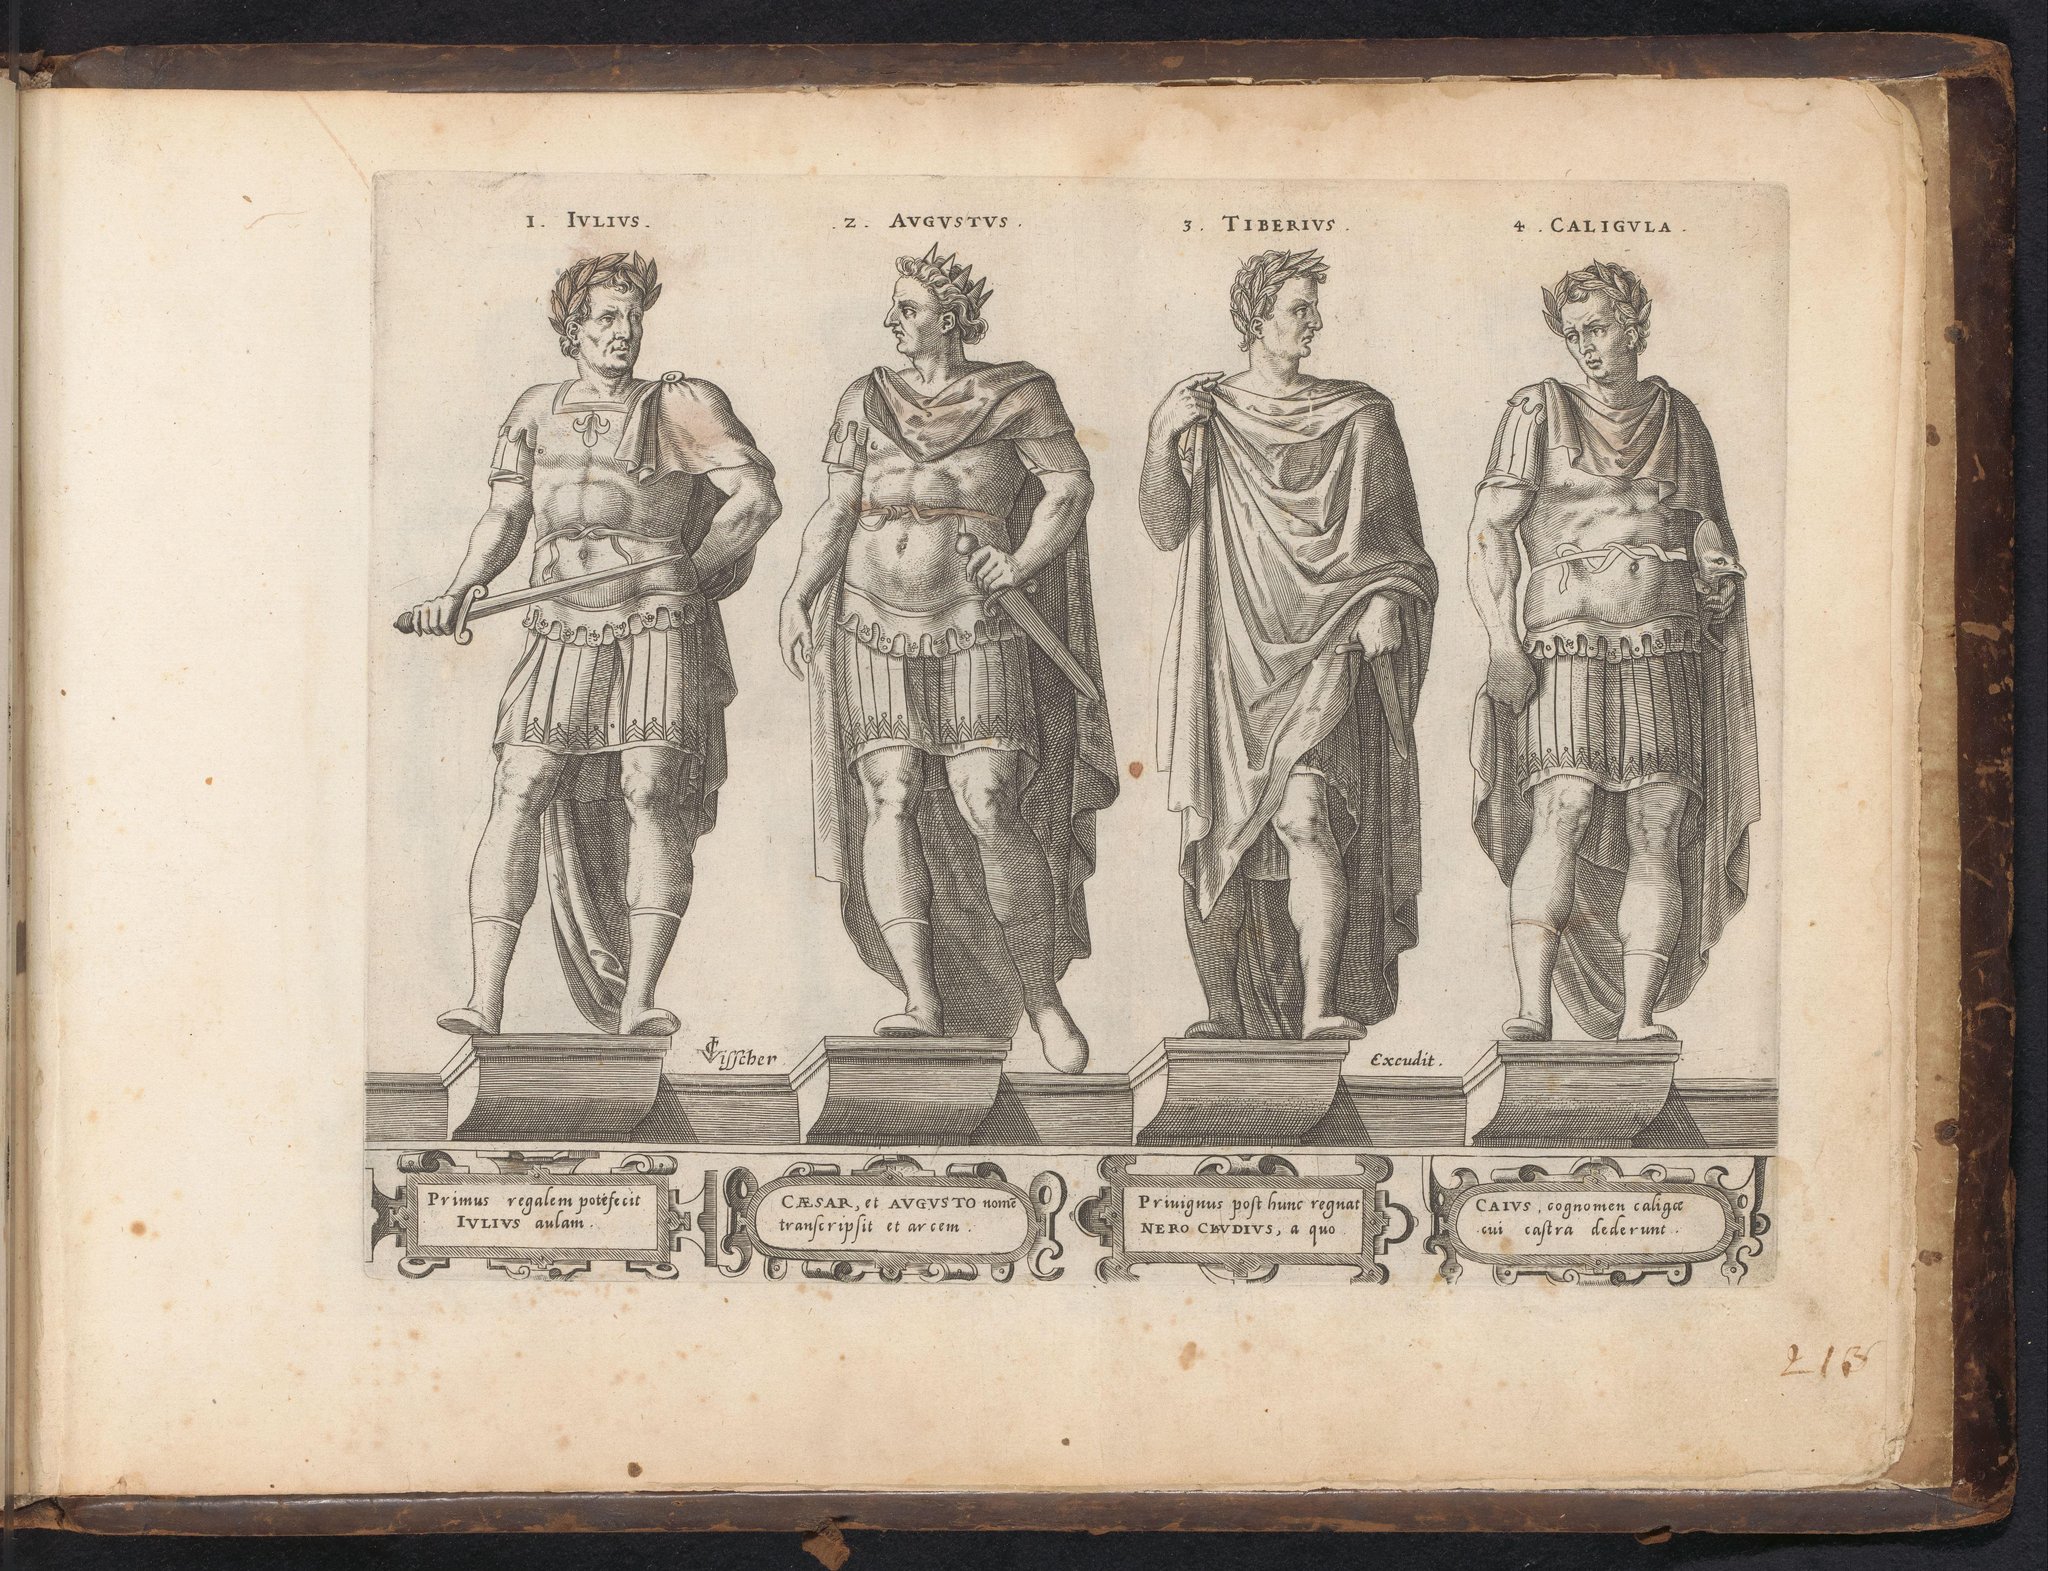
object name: print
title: Twaalf Romeinse keizers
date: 1646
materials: paper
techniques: engraving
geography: amsterdam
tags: rome, miseno, germany, (story of) c. julius caesar, (story of) augustus, the roman emperor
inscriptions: number: ‘213’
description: Consoles met de eerste vier keizers van het Romeinse Rijk. Afgebeeld ten voeten uit: Julius Caesar, Augustus, Tiberius en Caligula. De tekst in de cartouches daaronder zijn versregels uit de Monosticha de Ordine Imperatorum van de Latijns dichter Decimus Magnus Ausonius. De prent maakt deel uit van een album.